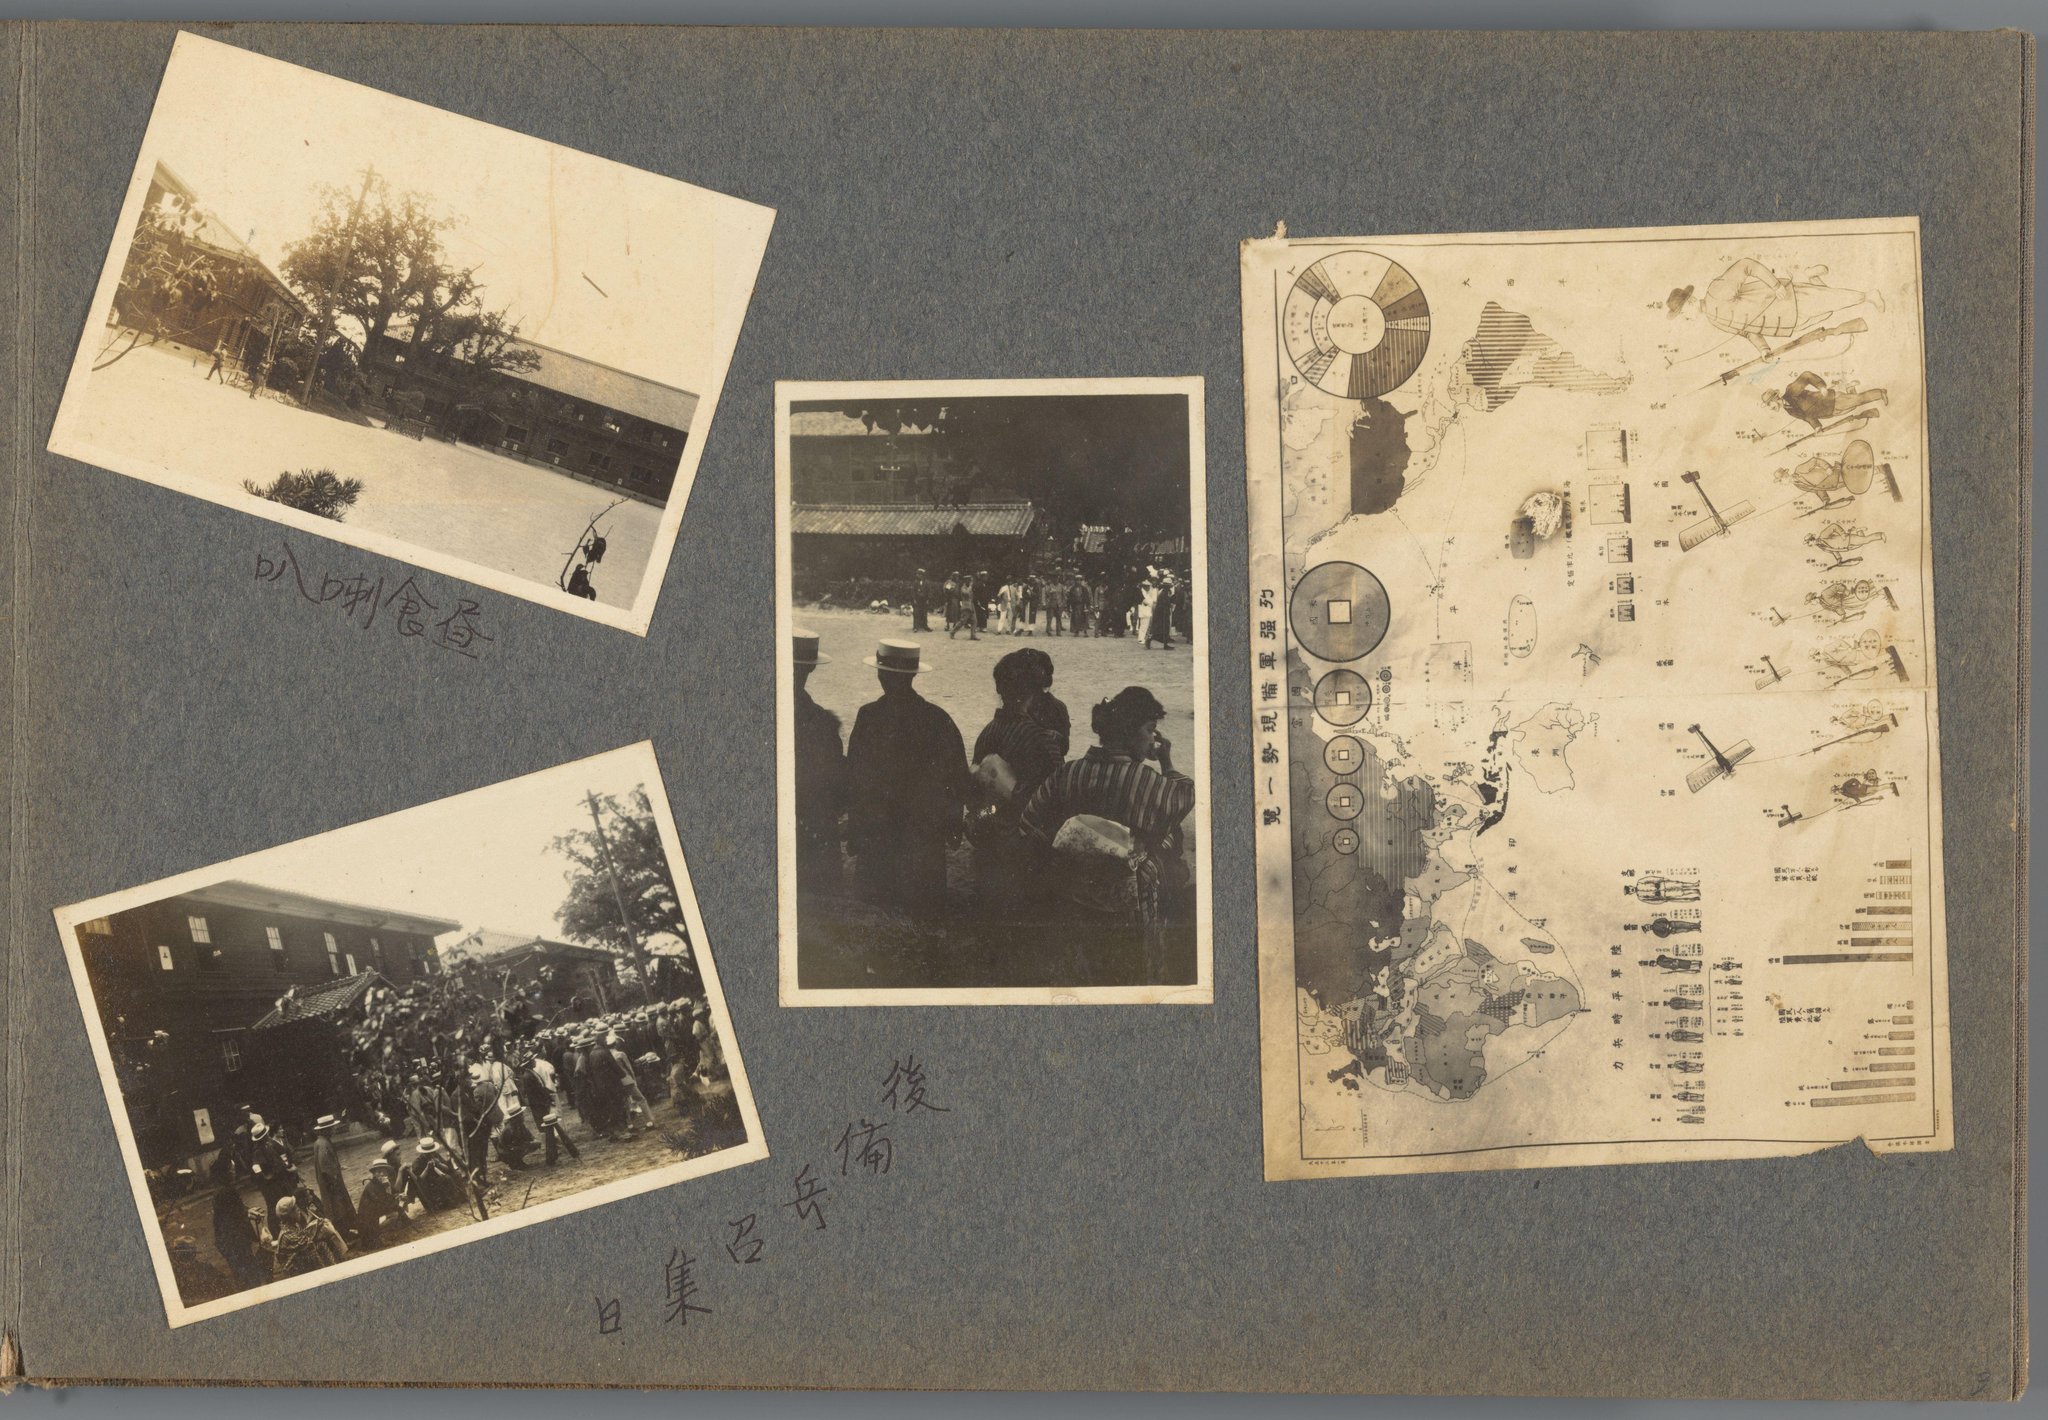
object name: album leaf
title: Burgerbezoek in het militaire kamp en wereldkaartje met vergelijkingen van nationale legers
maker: Anonymous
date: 1930-1940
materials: cardboard, photographic support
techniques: gelatin silver print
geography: japan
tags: soldiers and civilians, military training, military celebrations, japan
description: Albumblad met vier foto's van het leven van Japanse militairen. Bij de foto's opschriften in het Japans. Onderdeel van het leporello fotoalbum met foto’s van de diensttijd van Japanse militairen.